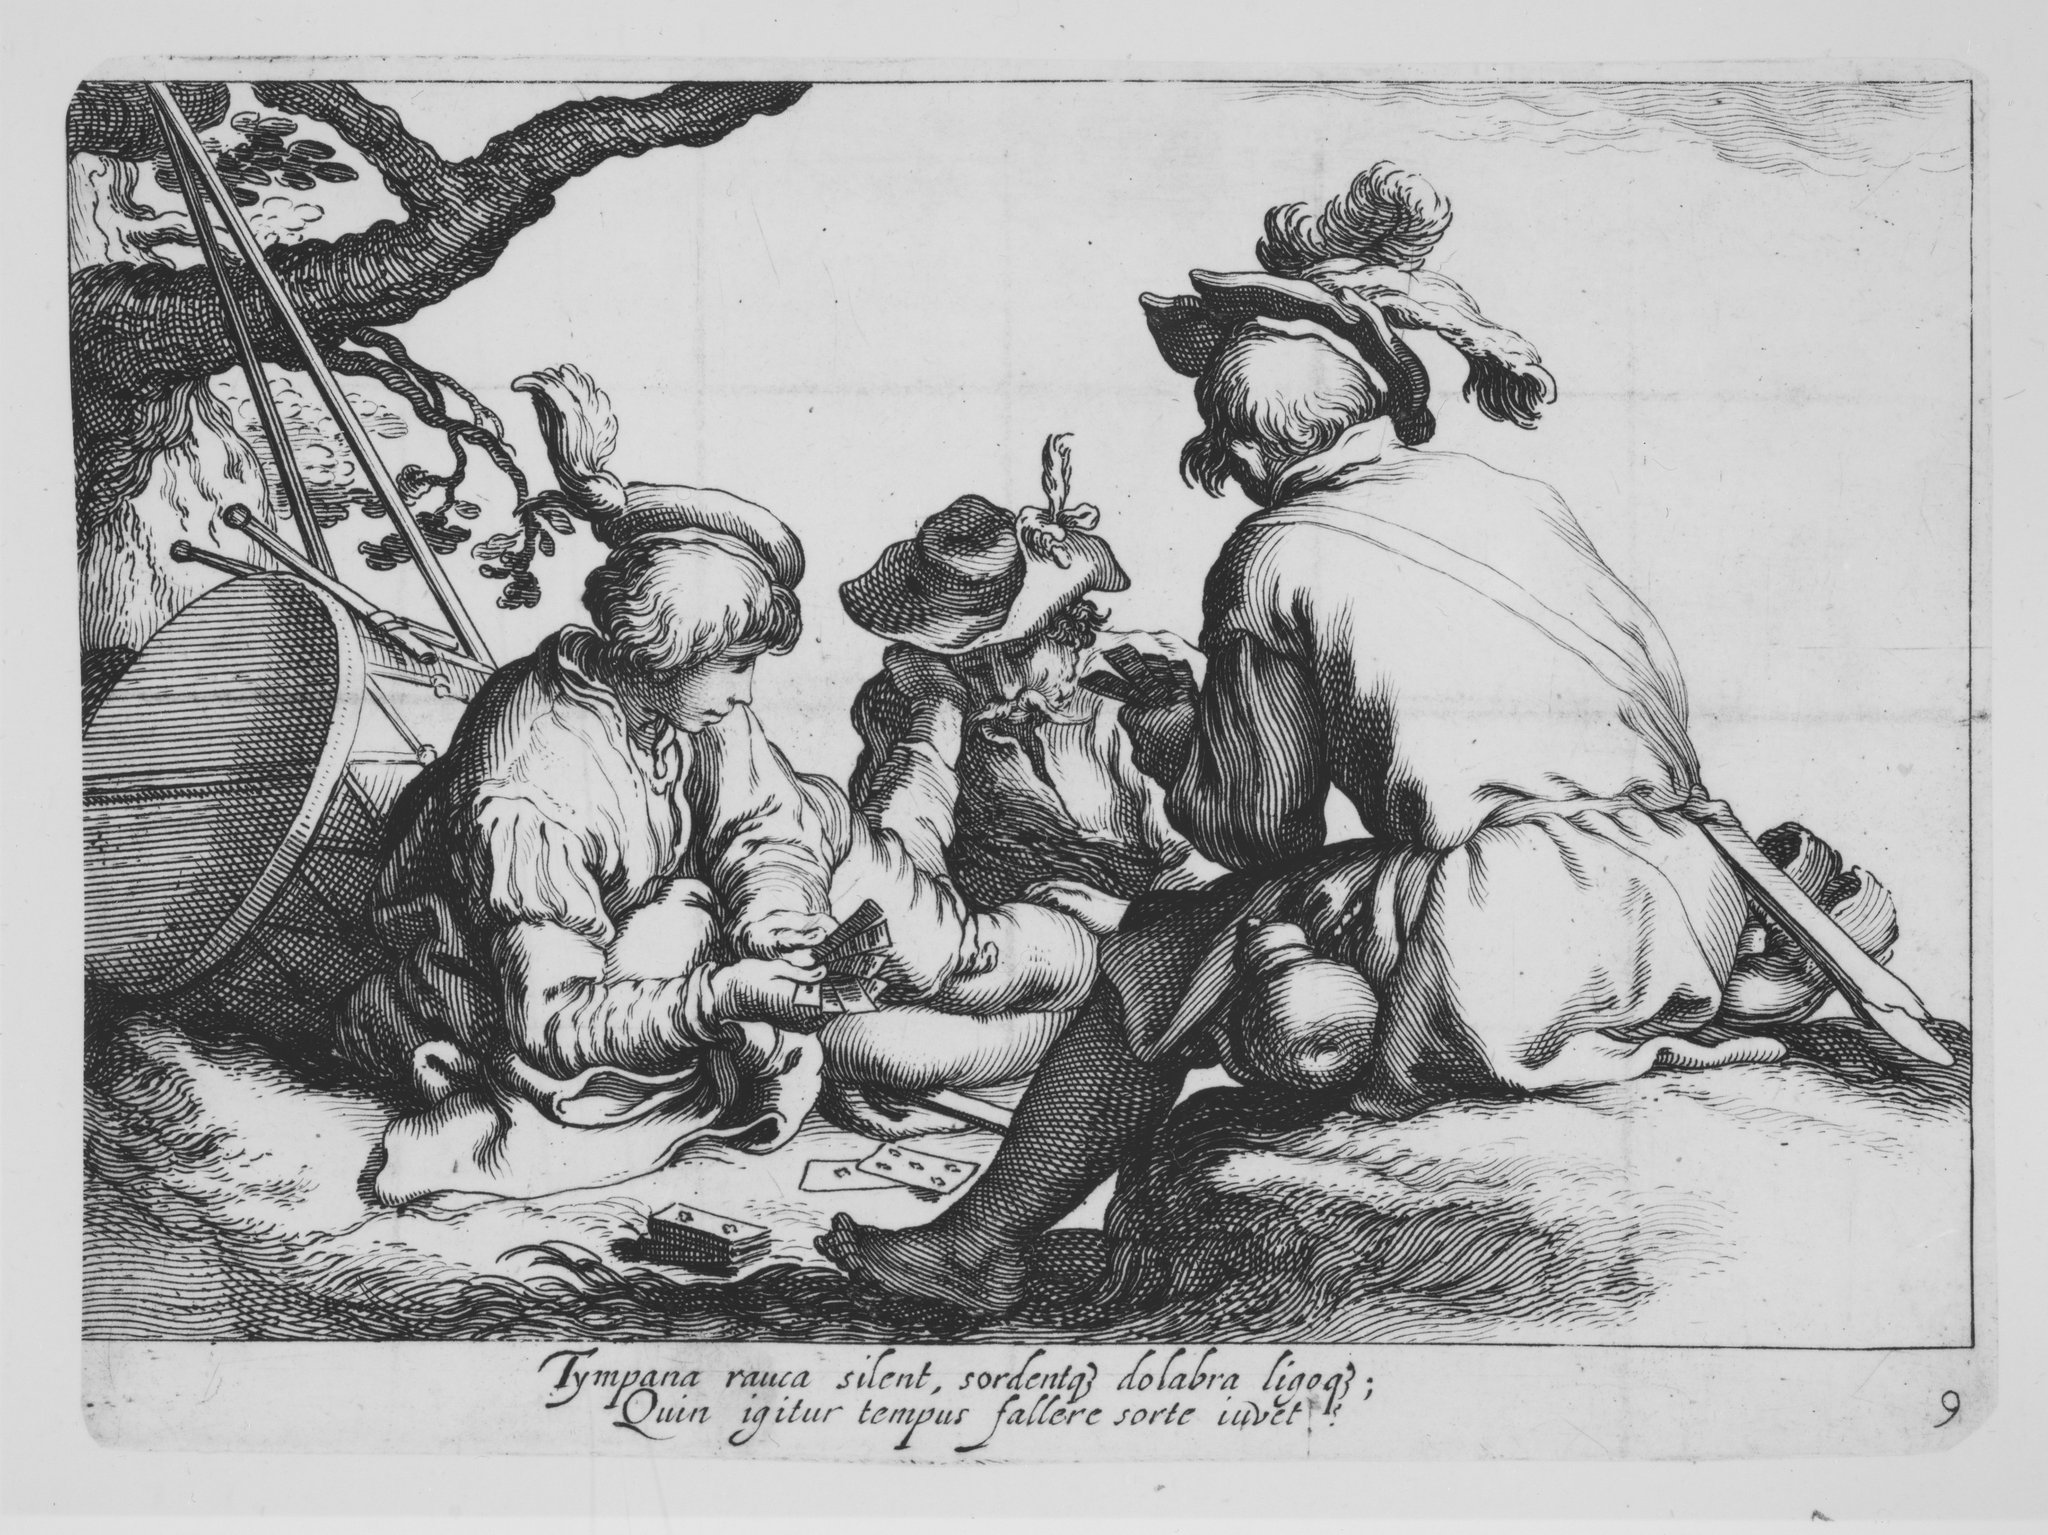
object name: print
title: Soldiers Playing Cards, from "Sixteen Peasant Subjects"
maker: cornelis bloemaert (ii)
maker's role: artist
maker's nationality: dutch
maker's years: 1603-1684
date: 1601-1700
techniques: etching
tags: soldiers,playing cards,drums